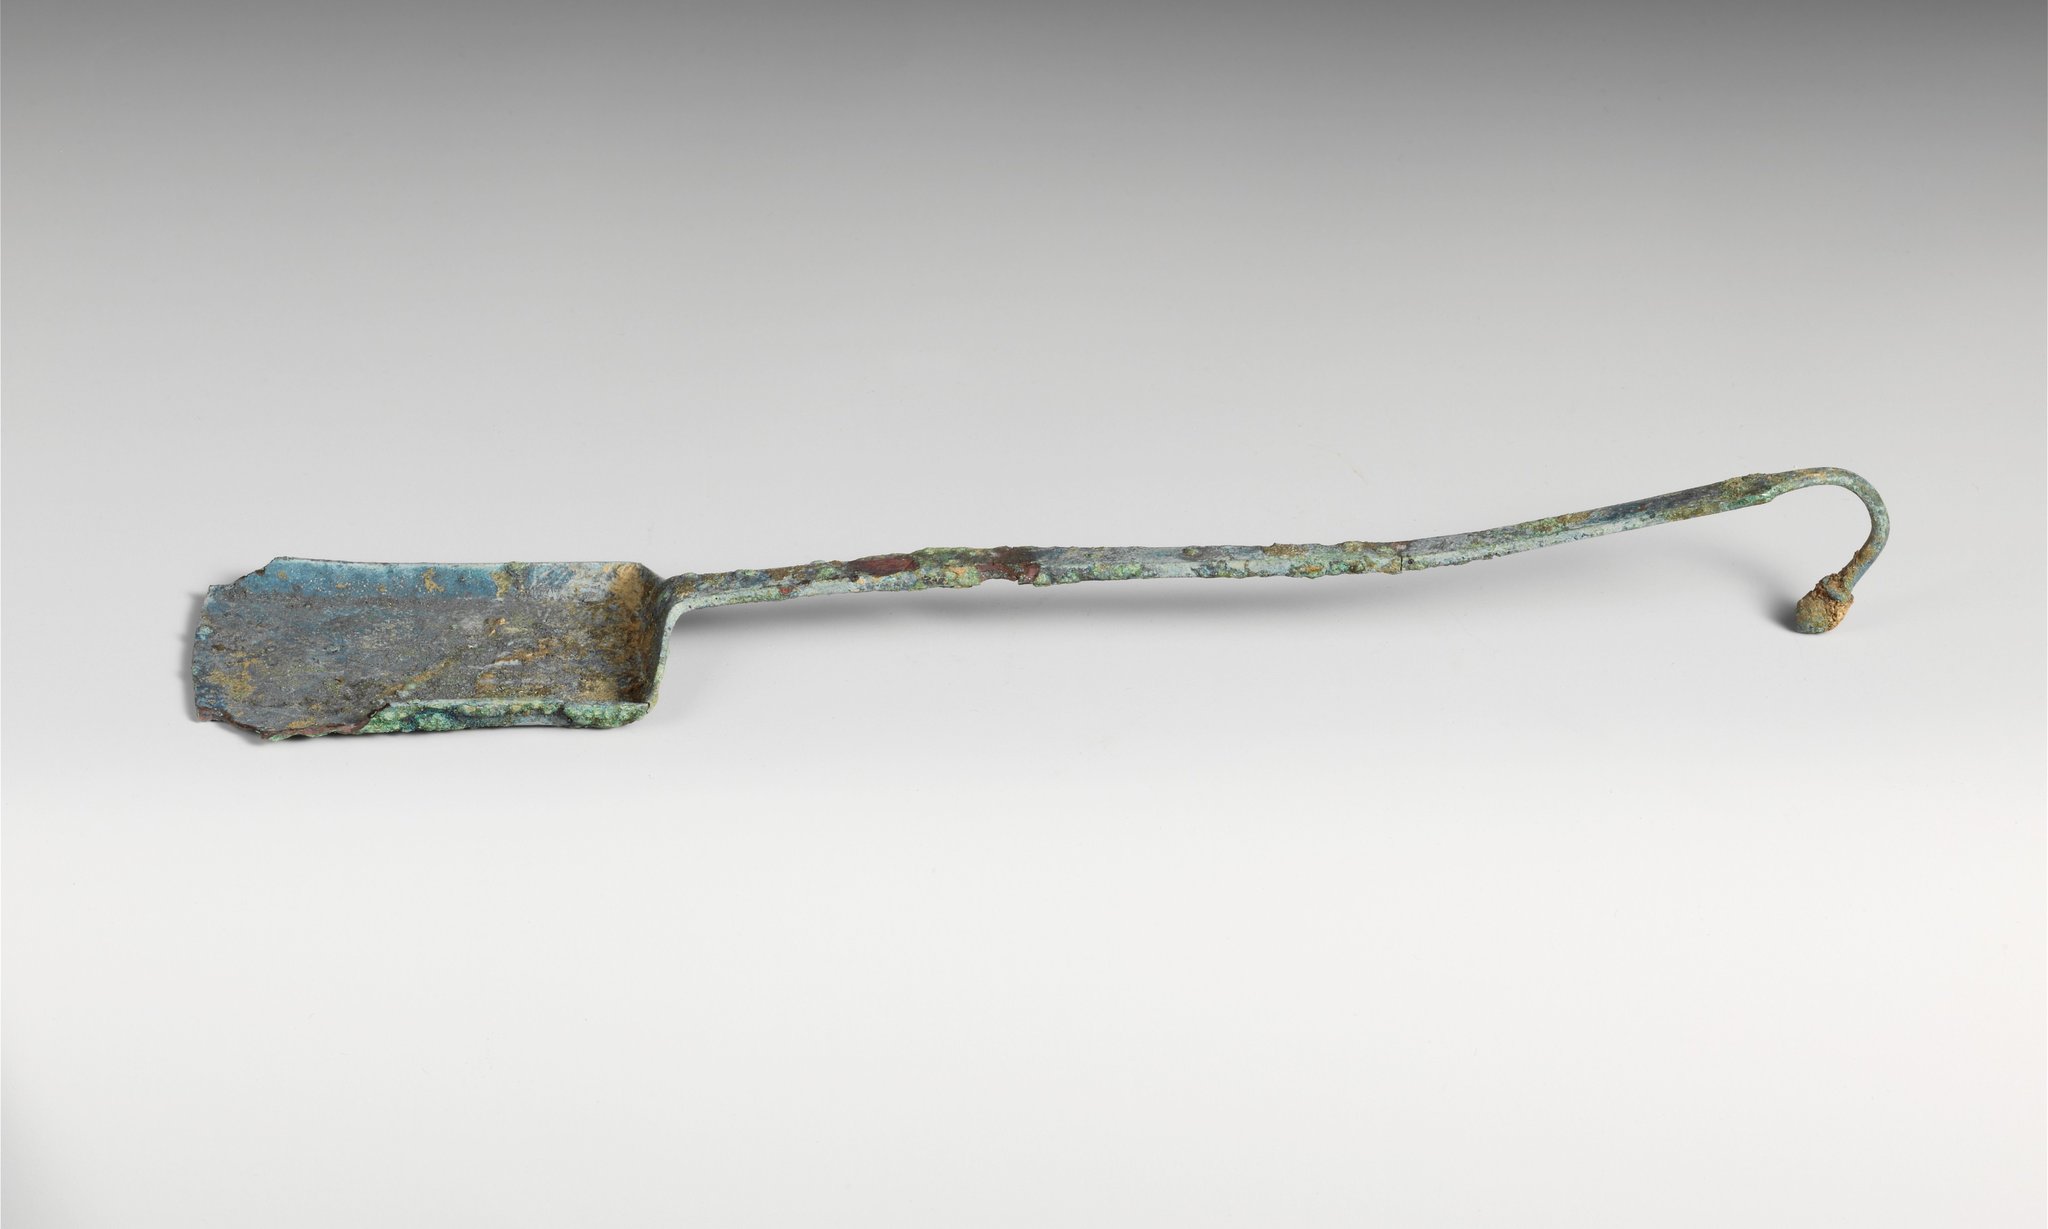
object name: shovel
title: Bronze shovel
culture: etruscan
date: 500-401 BCE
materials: bronze